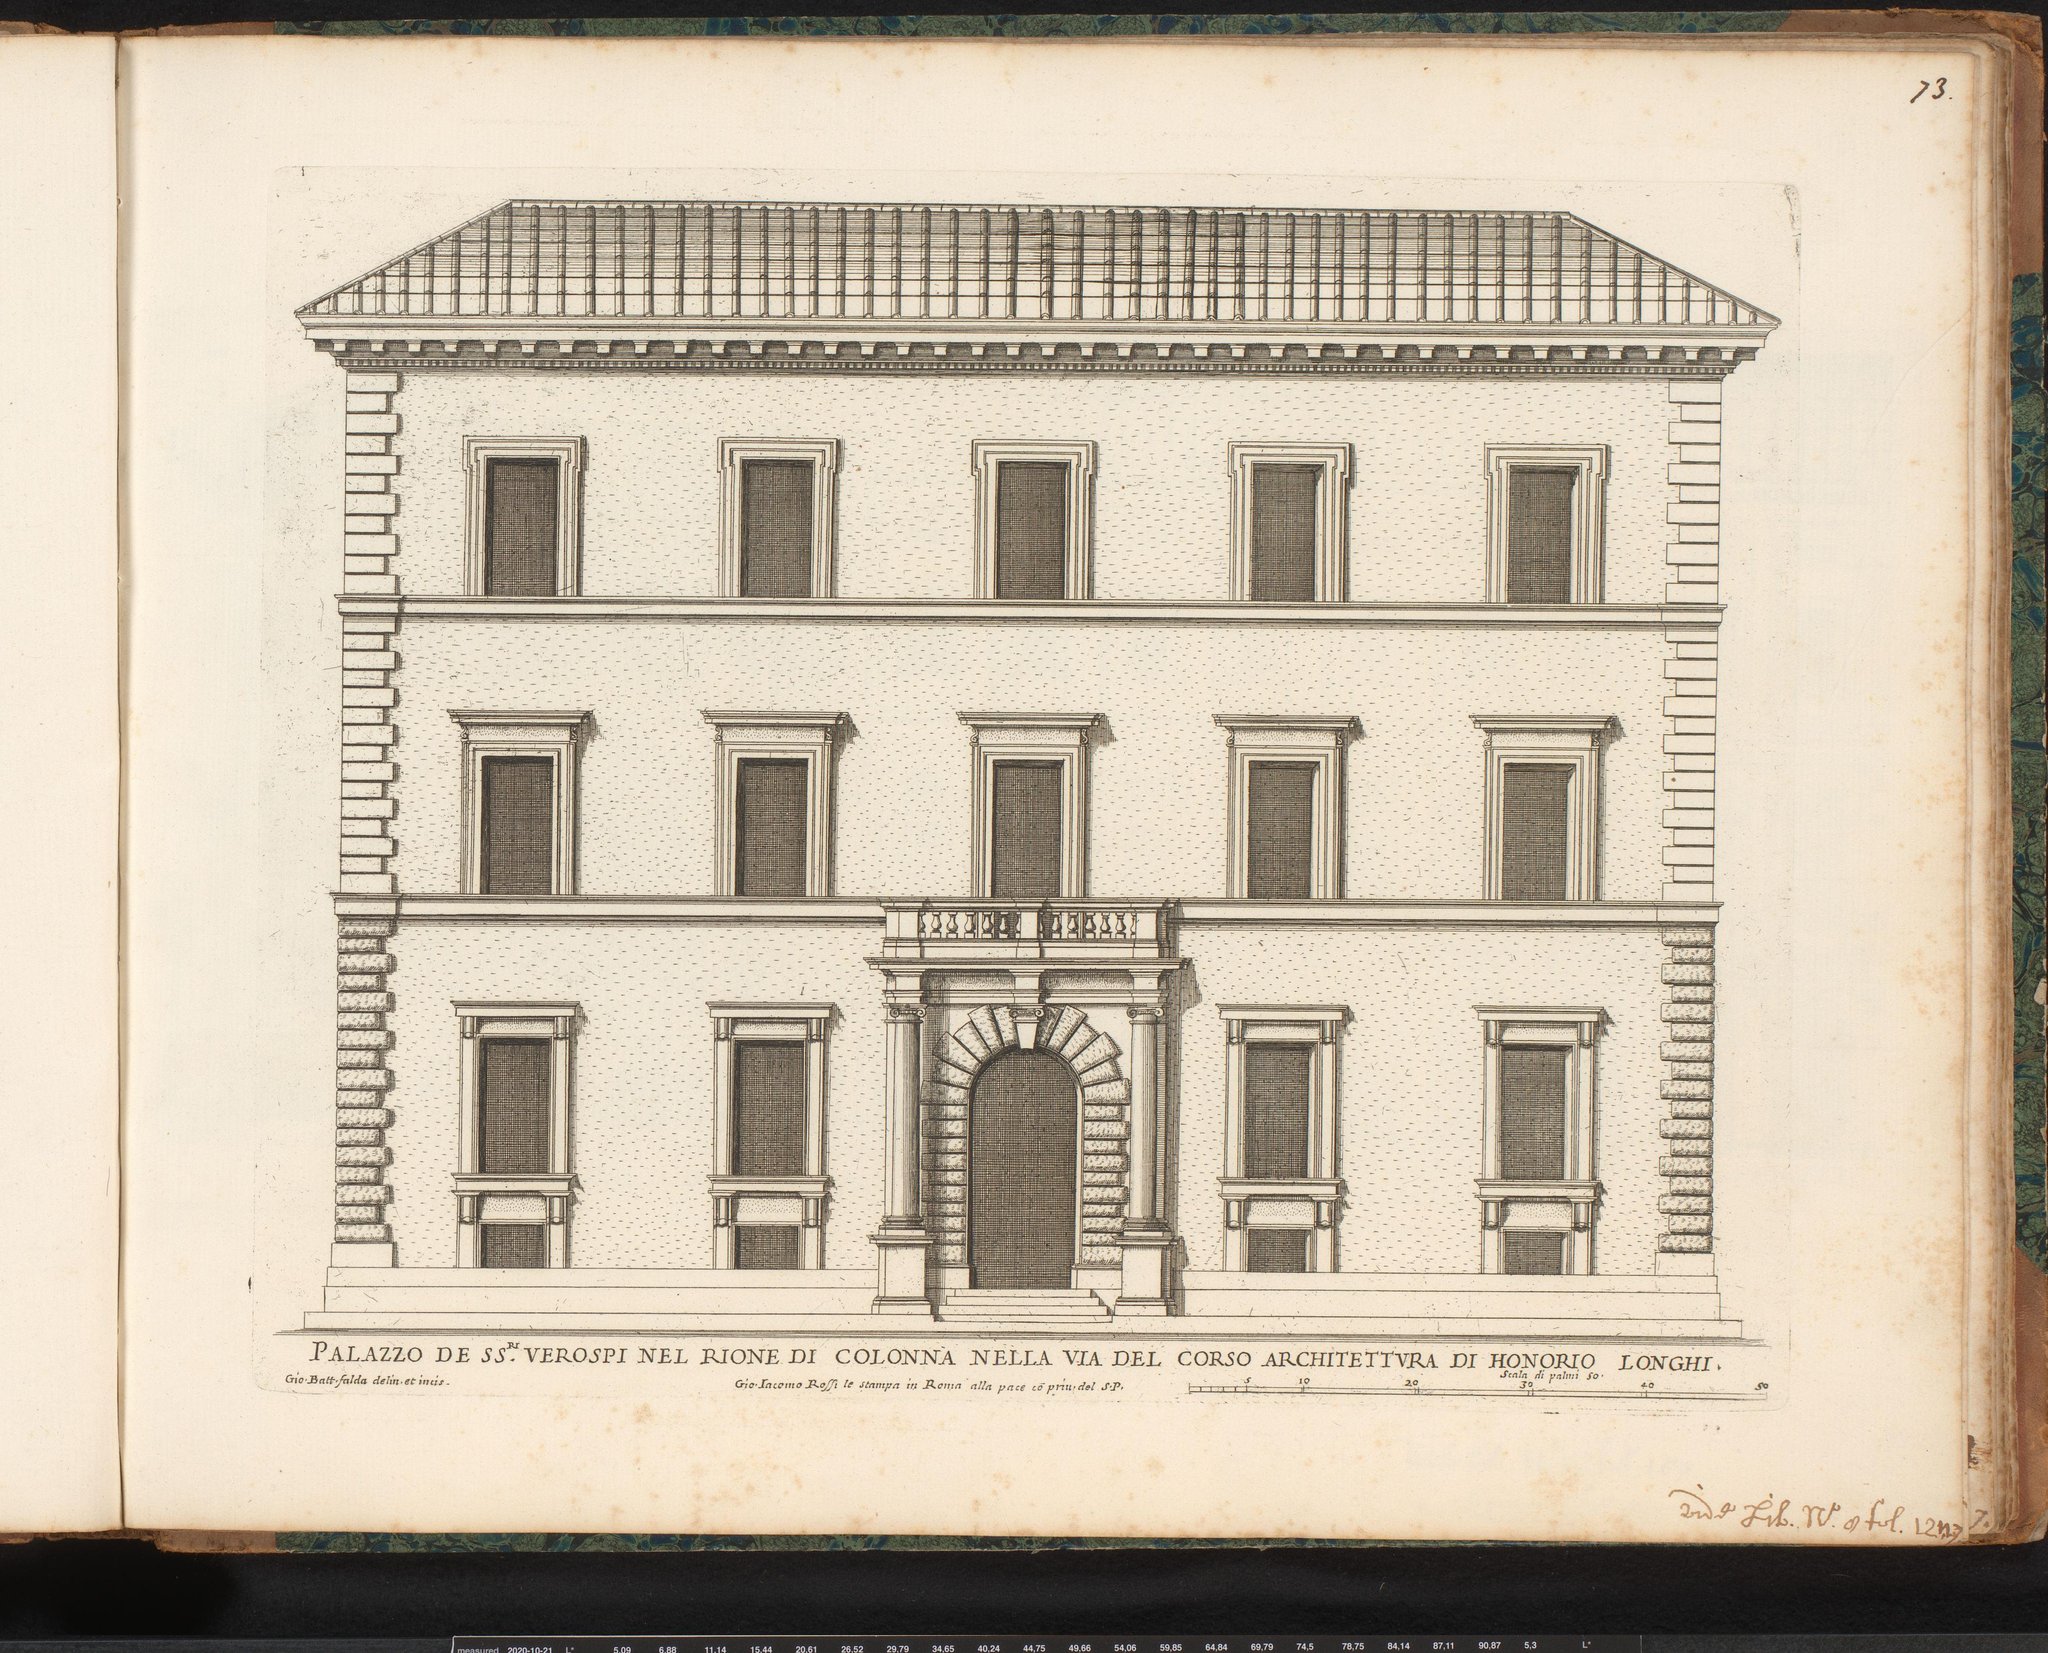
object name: print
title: Palazzi di Roma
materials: paper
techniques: etching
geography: rome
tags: palace, façade (of house or building)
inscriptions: number: ‘73’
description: Deze prent maakt deel uit van de reeks getiteld: Palazzi di Roma. Deze reeks bestaat uit twee boeken. Boek één getiteld: Palazzi di Roma dei più celebri architetti..., bestaat uit 44 prenten die worden toegeschreven aan Giovanni Battista Falda (naam staat enkel op prent 27) en uitgegeven door Giovanni Giacomo de'Rossi. Deze 44 prenten zijn bekend in twee staten (met en zonder nummer). Boek twee getiteld: Nuovi disegni dell'architetture... libro secondo, bevat 66 prenten door Giovanni Battista Falda en Simone Felice. Deze 66 prenten zijn bekend in twee staten (met en zonder nummer).